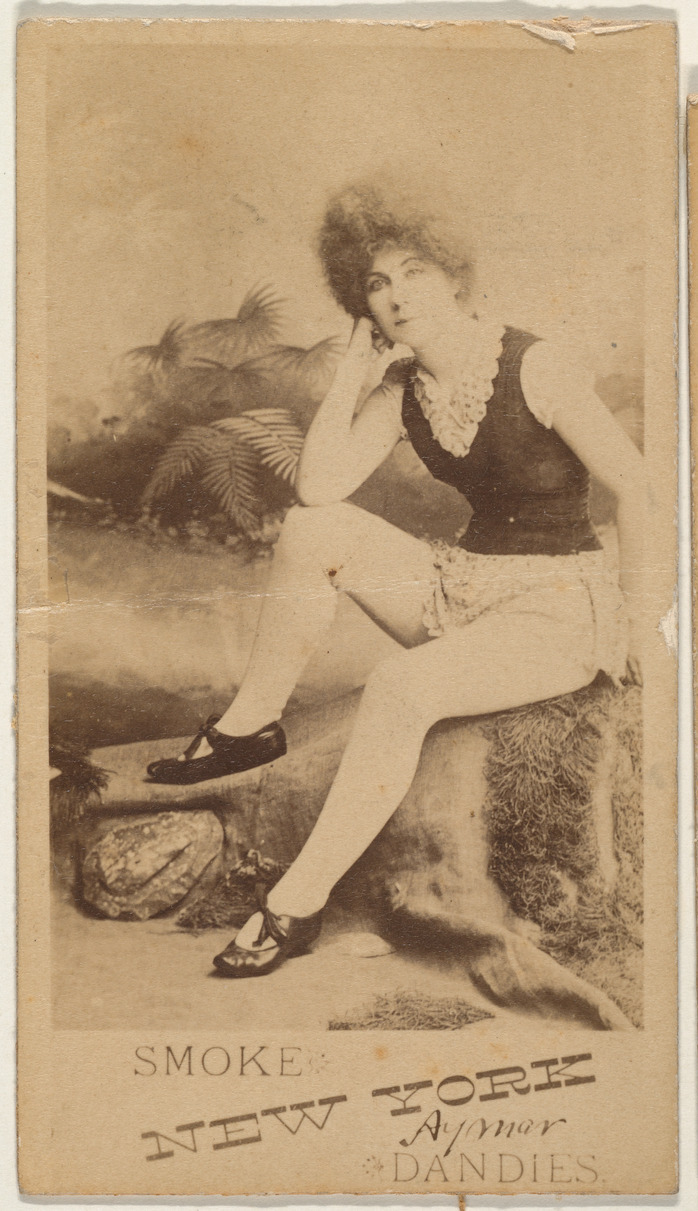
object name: photograph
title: Seated actress with head resting on hand, from the series Actresses (N674), promoting New York Dandies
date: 1888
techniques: albumen silver print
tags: portraits,women,actresses